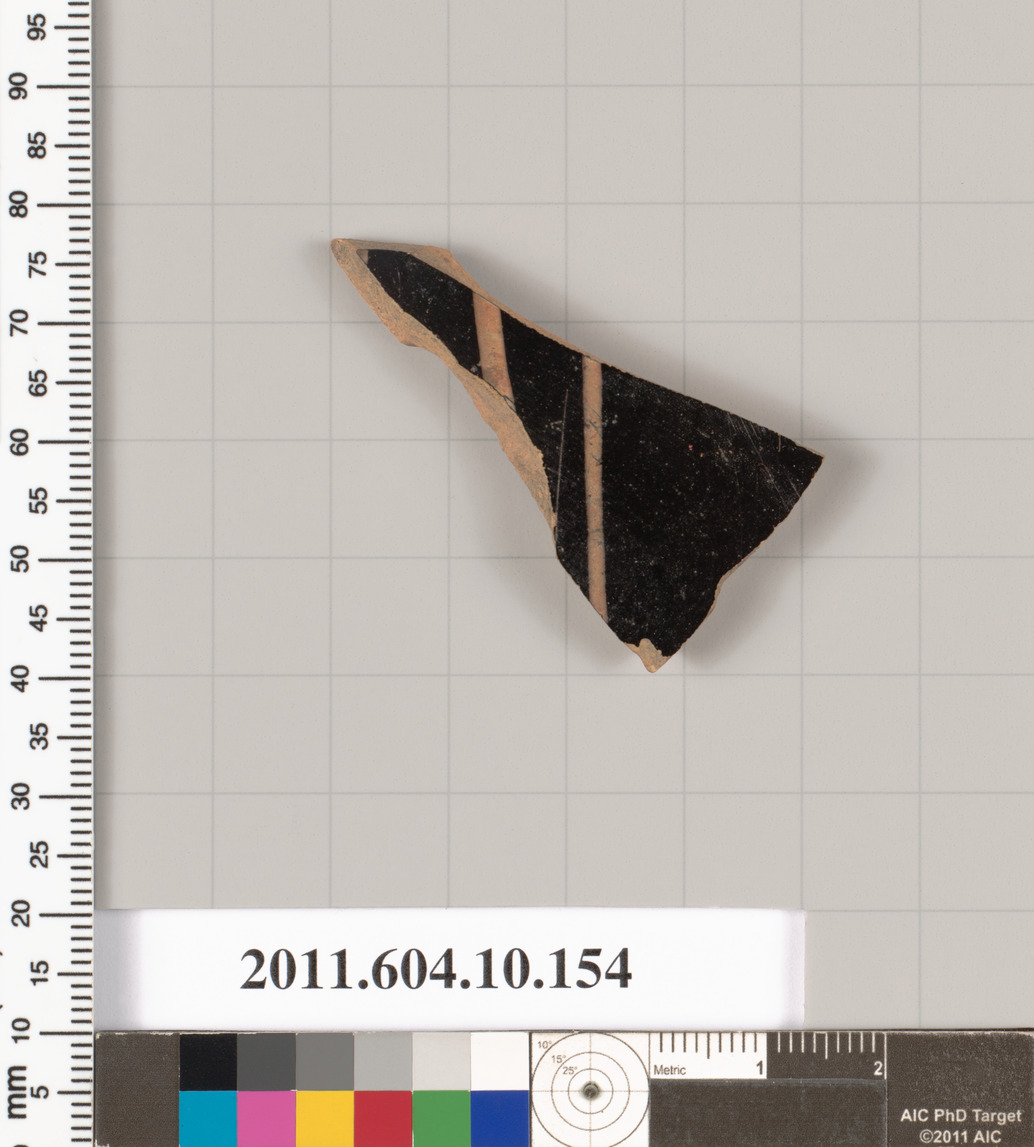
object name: skyphos fragment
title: Terracotta fragment of a skyphos (deep drinking cup)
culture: etruscan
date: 434-401 BCE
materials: terracotta